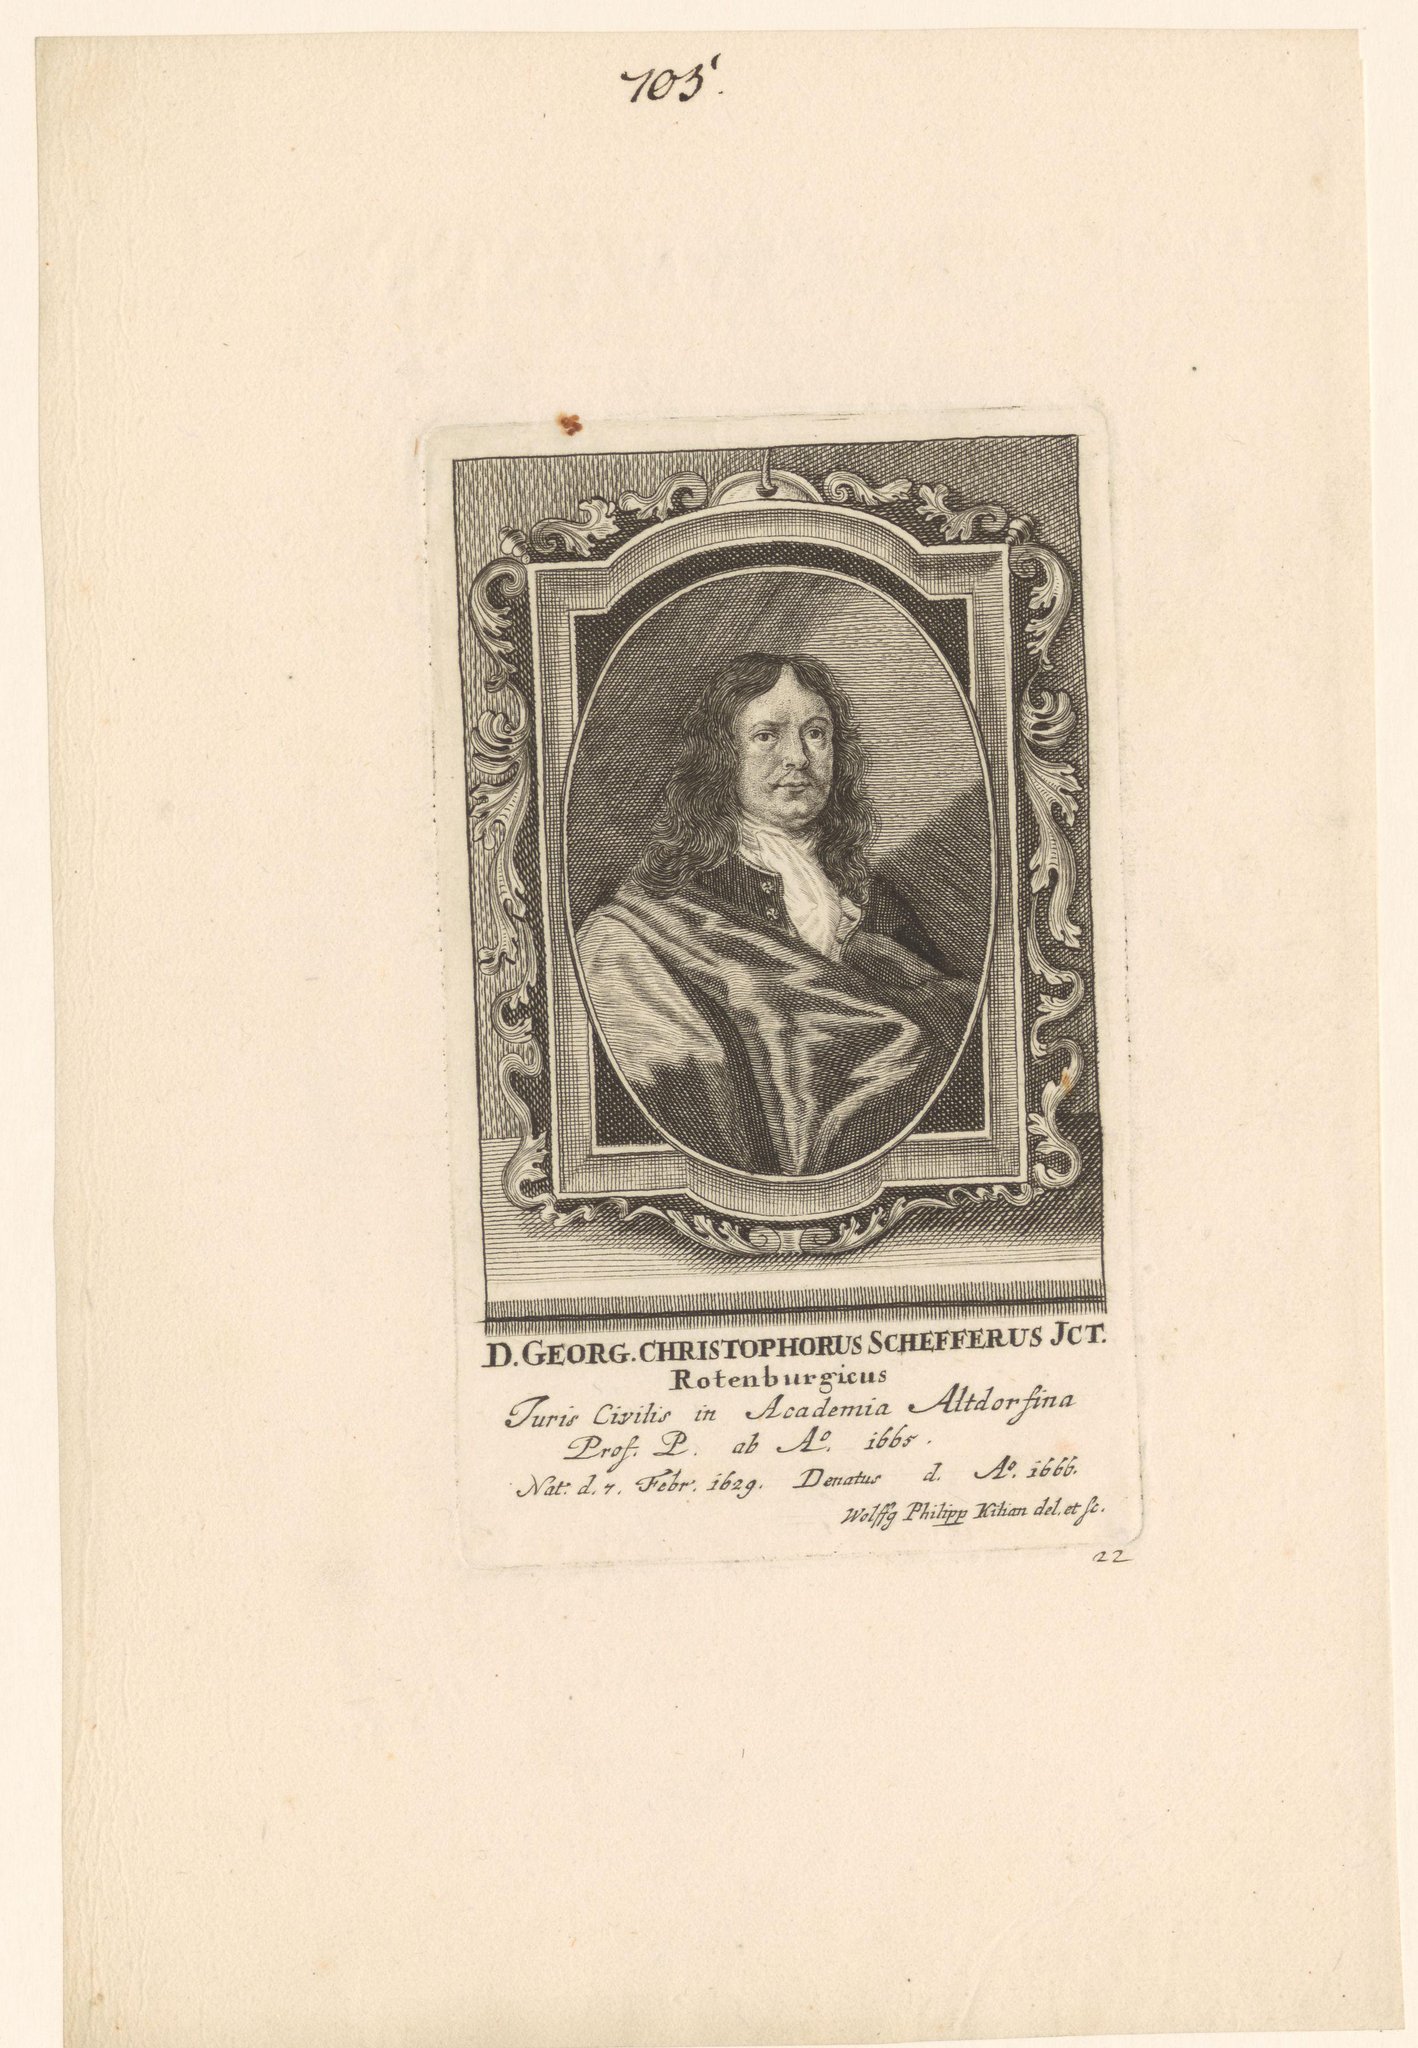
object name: print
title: Portret van Georg Christoph Schaeffer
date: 1669-1732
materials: paper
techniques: engraving, etching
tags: further education (+ portrait of teacher, professor), historical persons, lawyer, attorney at law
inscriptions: collector's mark: Lugt 2228, number: ‘22’